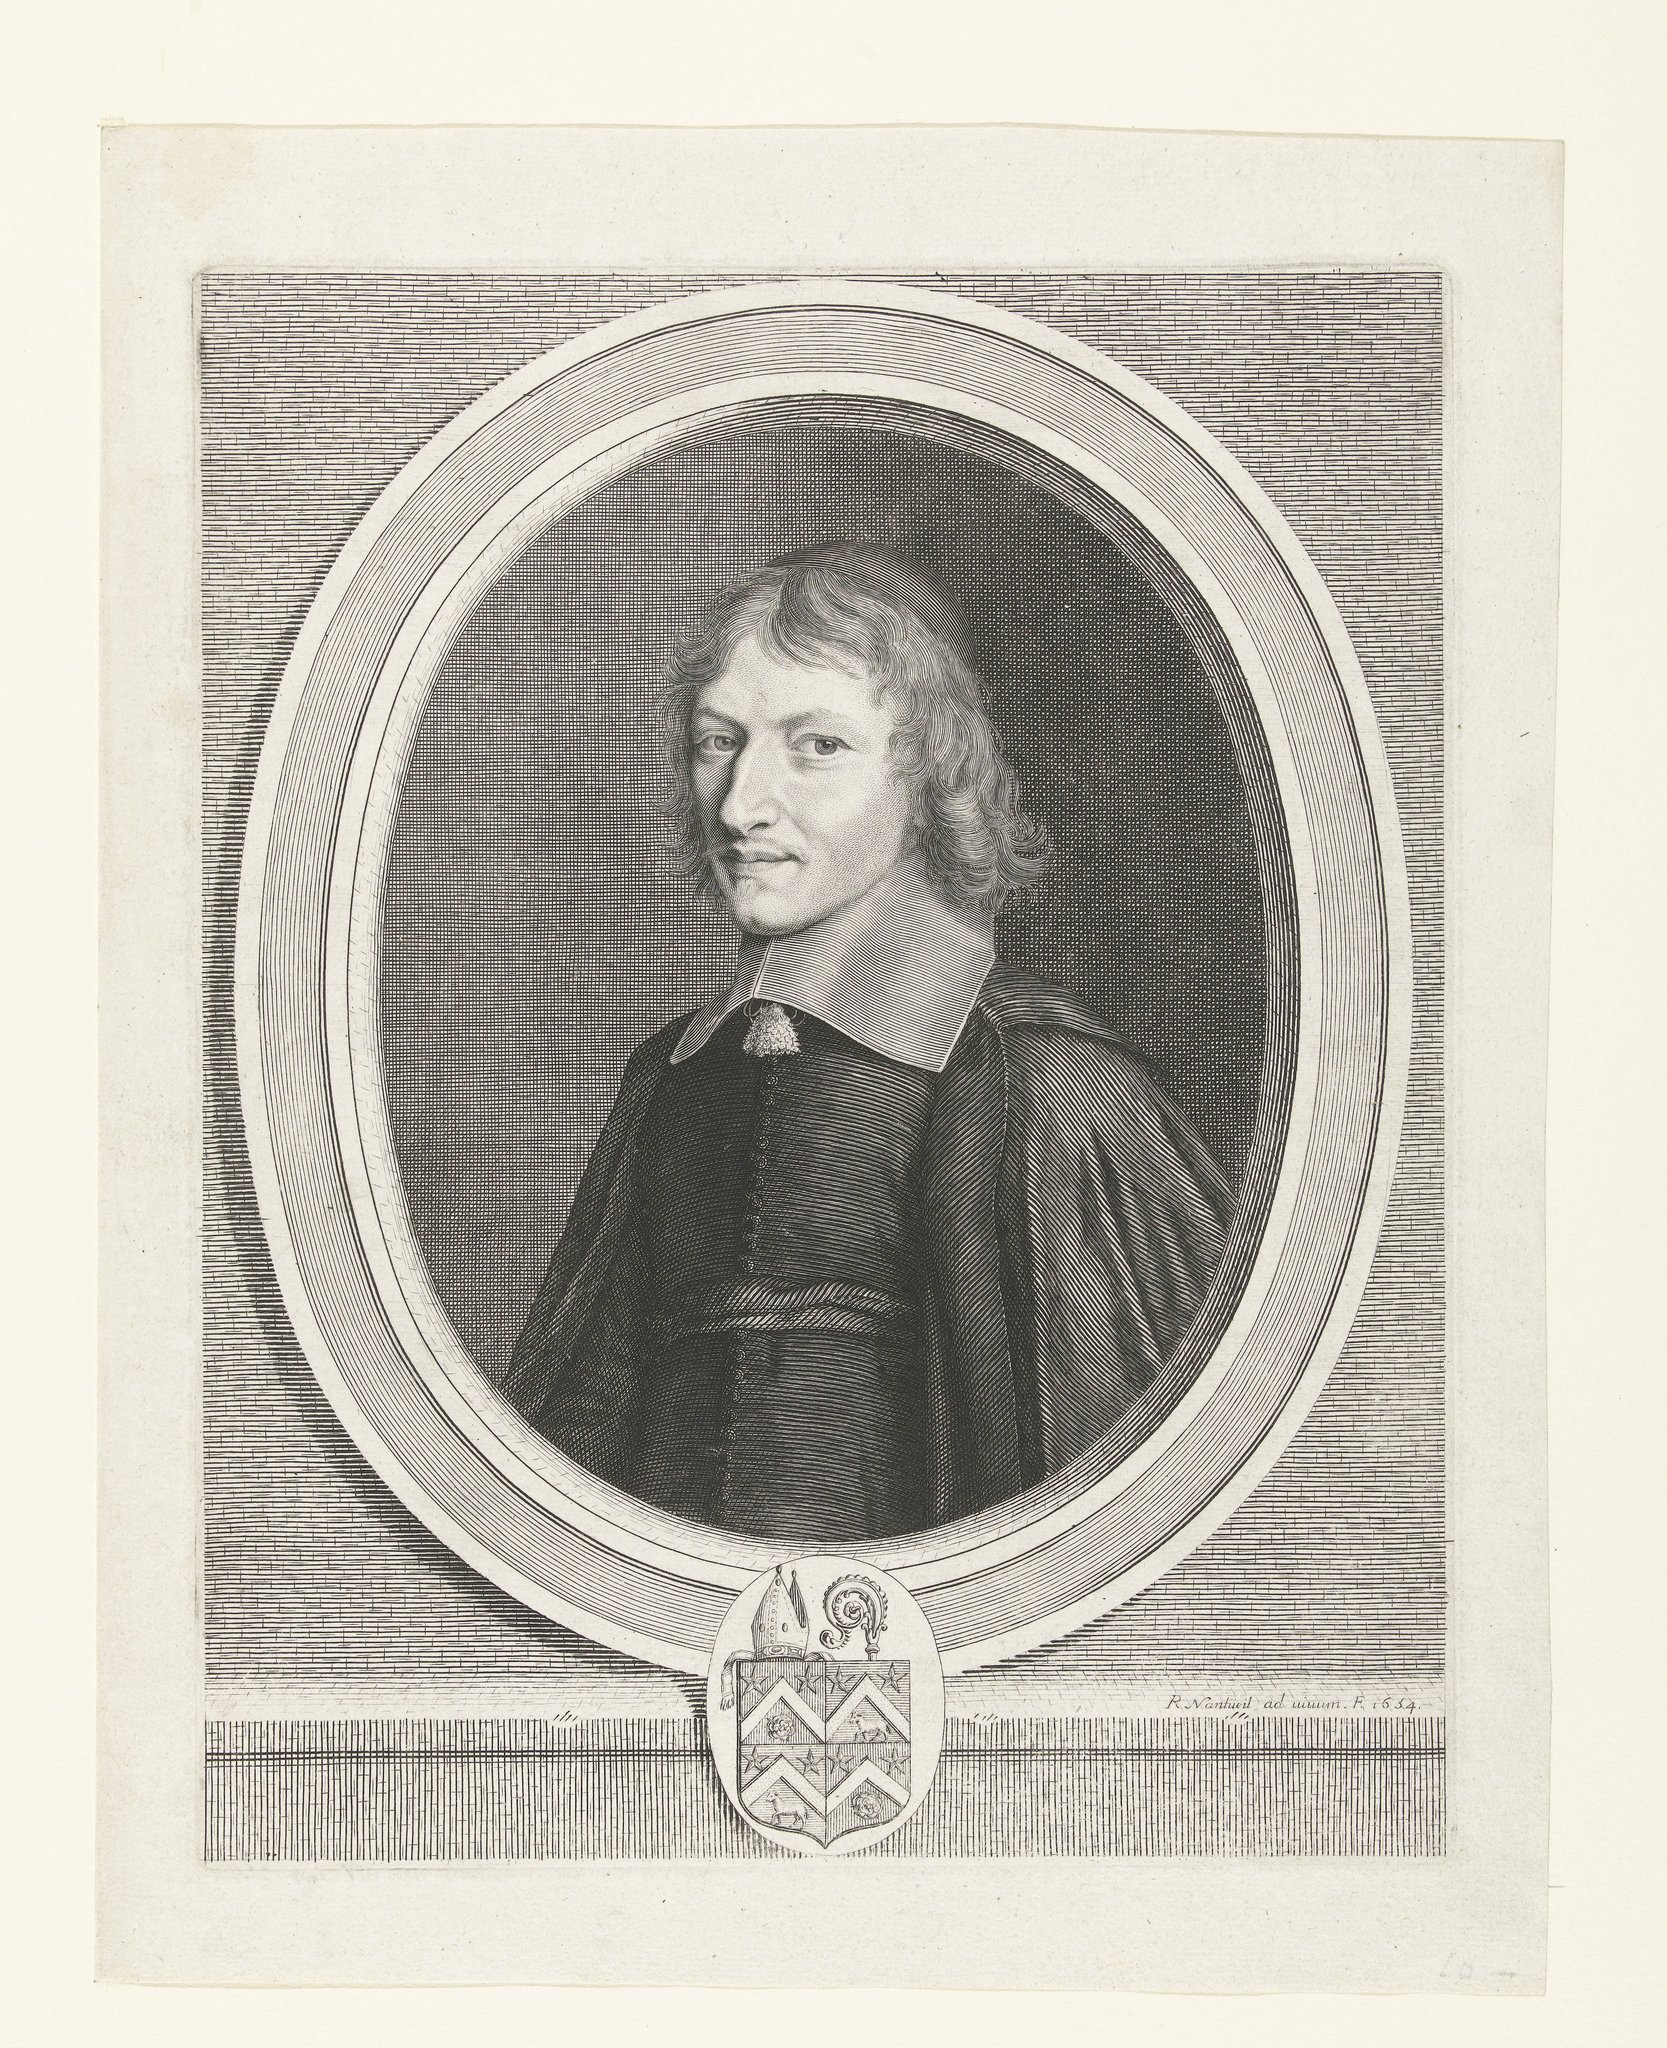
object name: print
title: Portret van Dominique de Ligny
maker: robert nanteuil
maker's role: print maker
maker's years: 1623-1678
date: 1654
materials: paper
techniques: engraving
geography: france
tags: clergyman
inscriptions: inscription: ‘(c) acm’, collector's mark: Lugt 2229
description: Portret van de bisschop Dominique de Ligny, in een ovale omlijsting met onderaan een wapenschild.